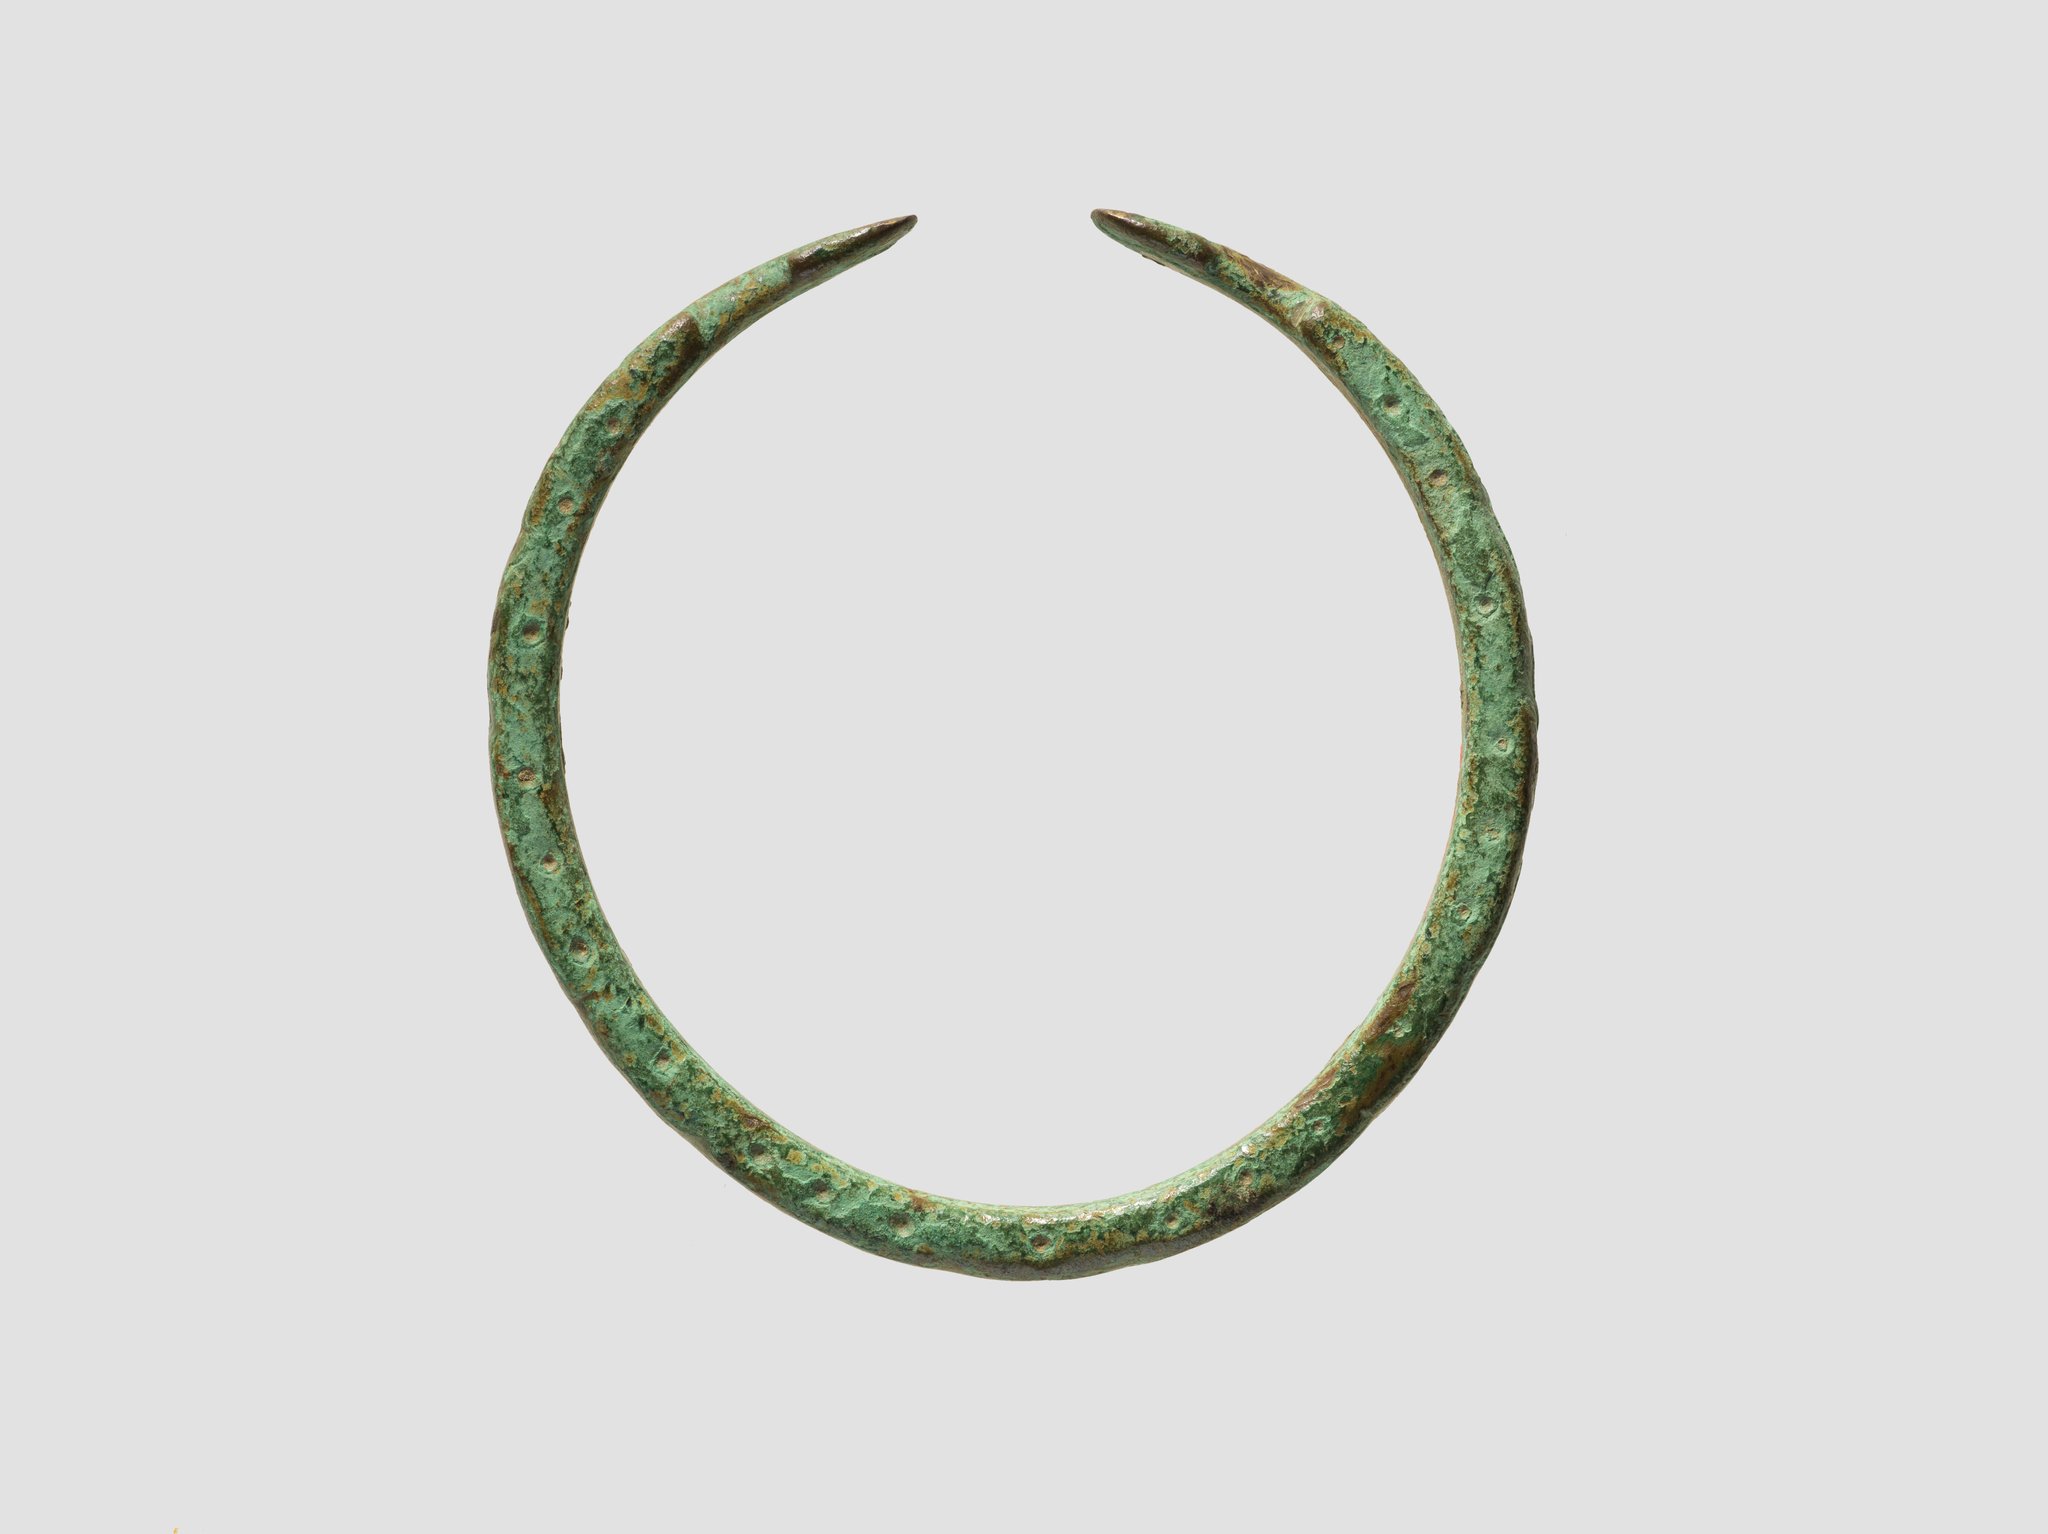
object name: bracelet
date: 1-1000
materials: bronze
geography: anatolia (?)